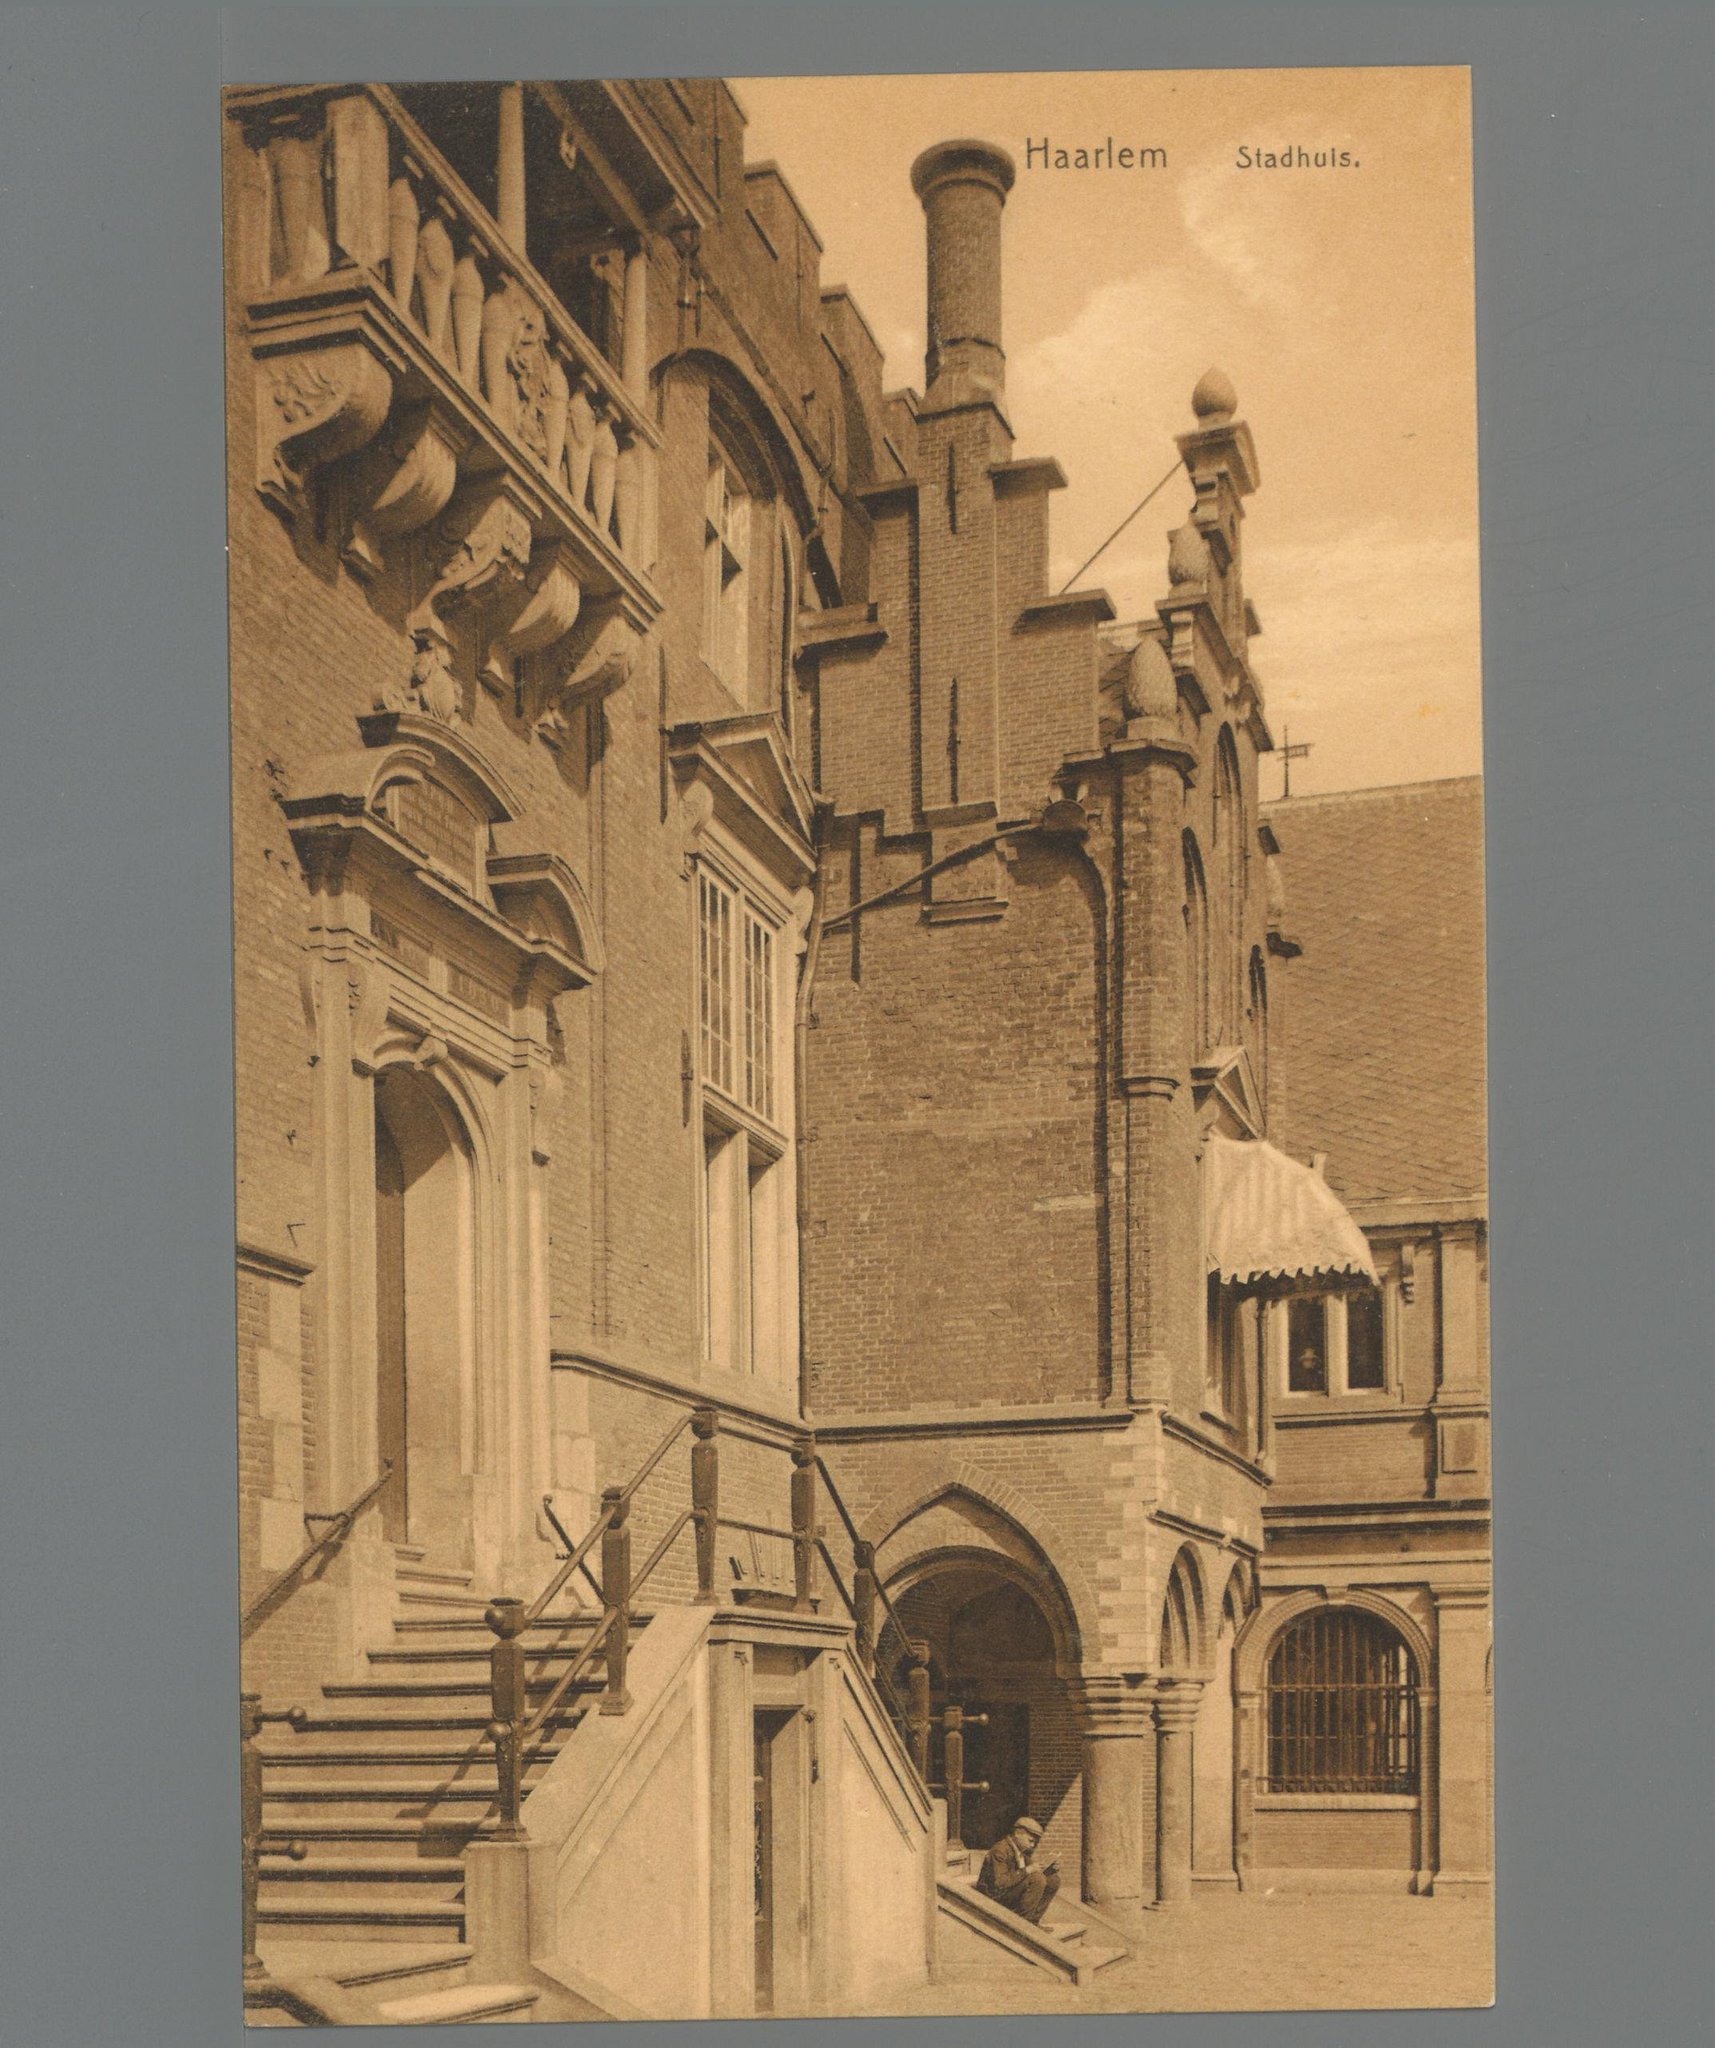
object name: ansichtkaart, prentbriefkaart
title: Haarlem. Stadhuis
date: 1906-1910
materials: cardboard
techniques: photograph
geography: hamburg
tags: townhall, haarlem